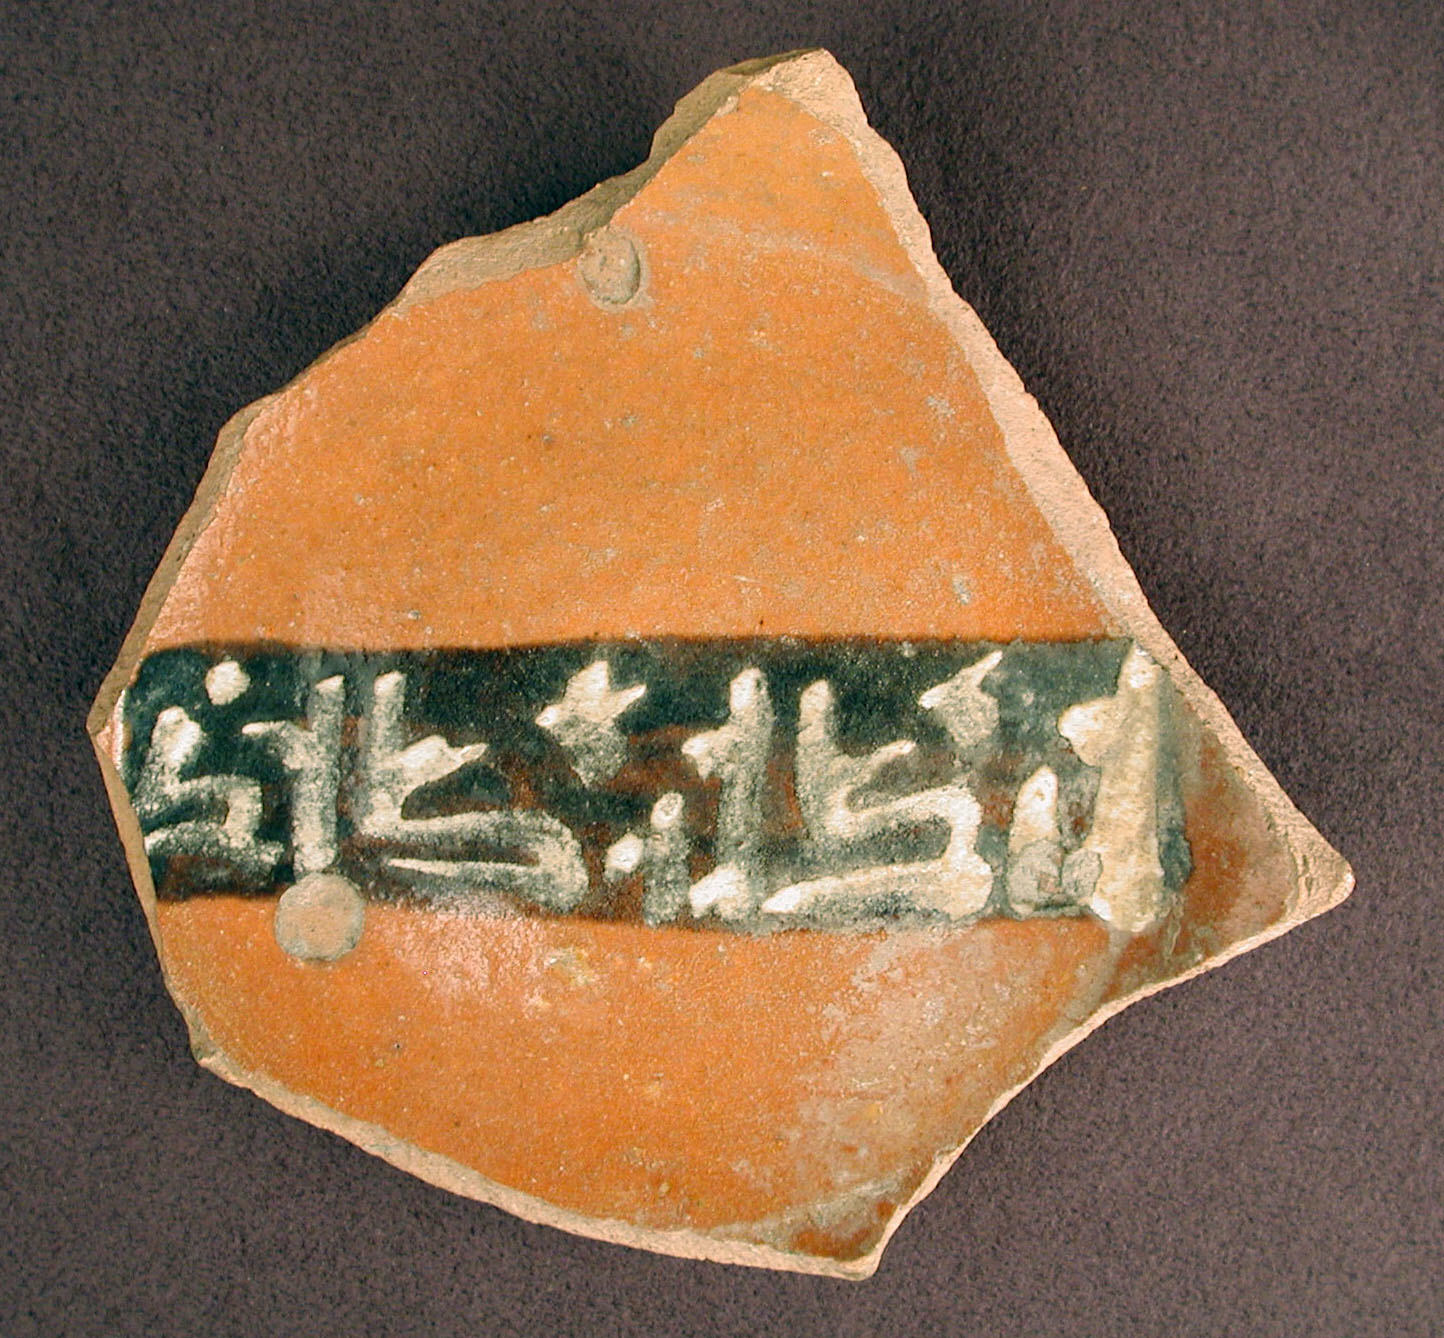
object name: fragment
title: Base of a Vessel with a White Slip Inscription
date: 801-1000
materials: earthenware, glaze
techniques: polychrome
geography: iran